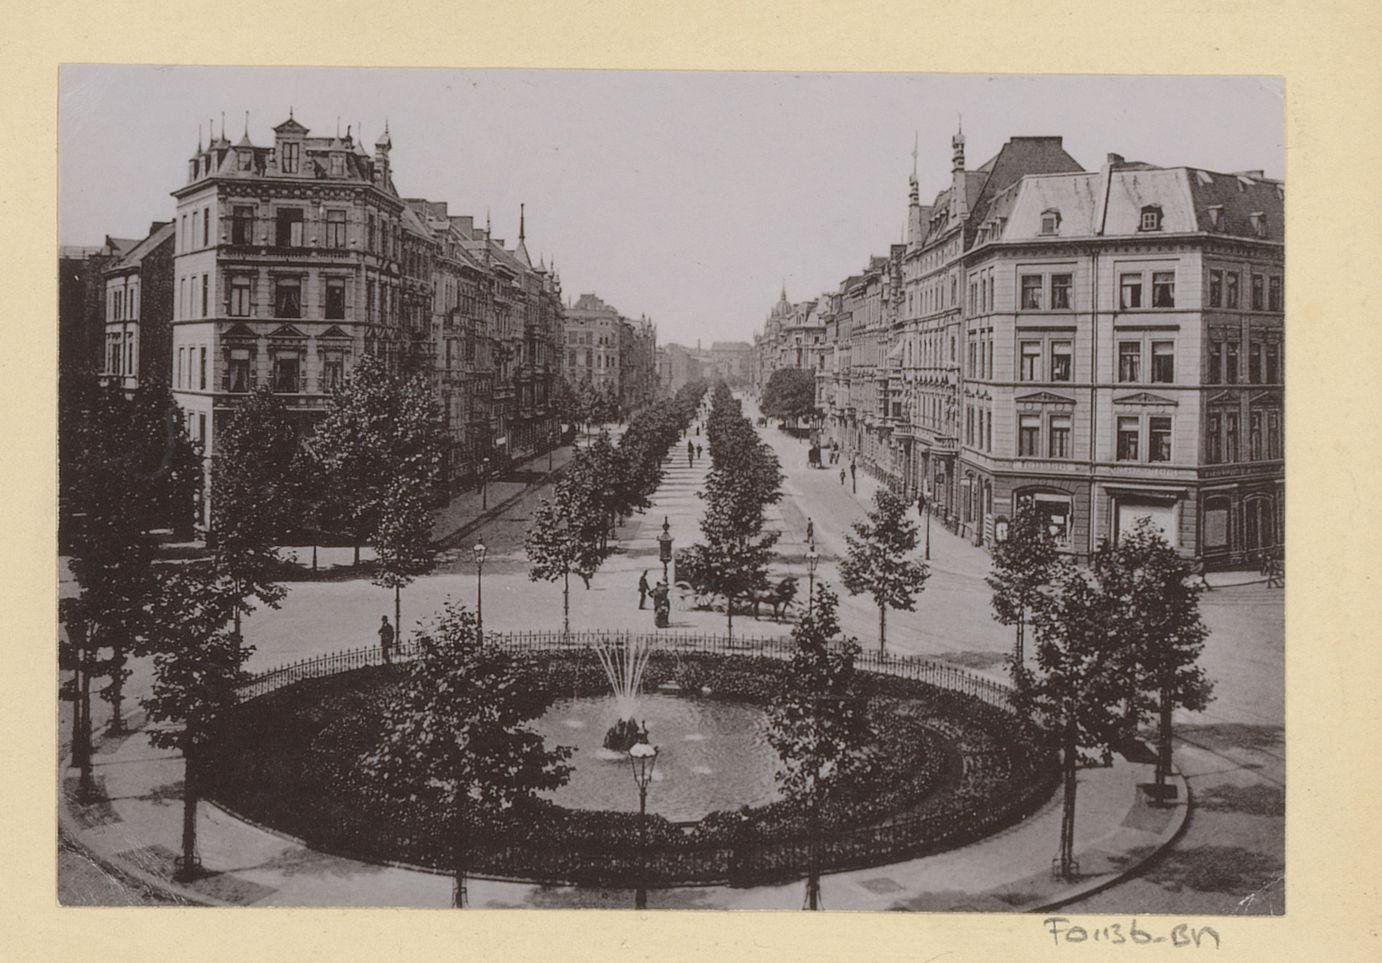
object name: photomechanical print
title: Barbarossaplatz en de Hohenstauffenring in Keulen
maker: Anonymous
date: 1880-1895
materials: paper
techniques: photograph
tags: square, place, circus, etc. (+ city(-scape) with figures, staffage), ornamental fountain (+ city(-scape) with figures, staffage), street (+ city(-scape) with figures, staffage), cologne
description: Onderdeel van Fotoalbum met opnames van bezienswaardigheden in België, Duitsland en Noorwegen.